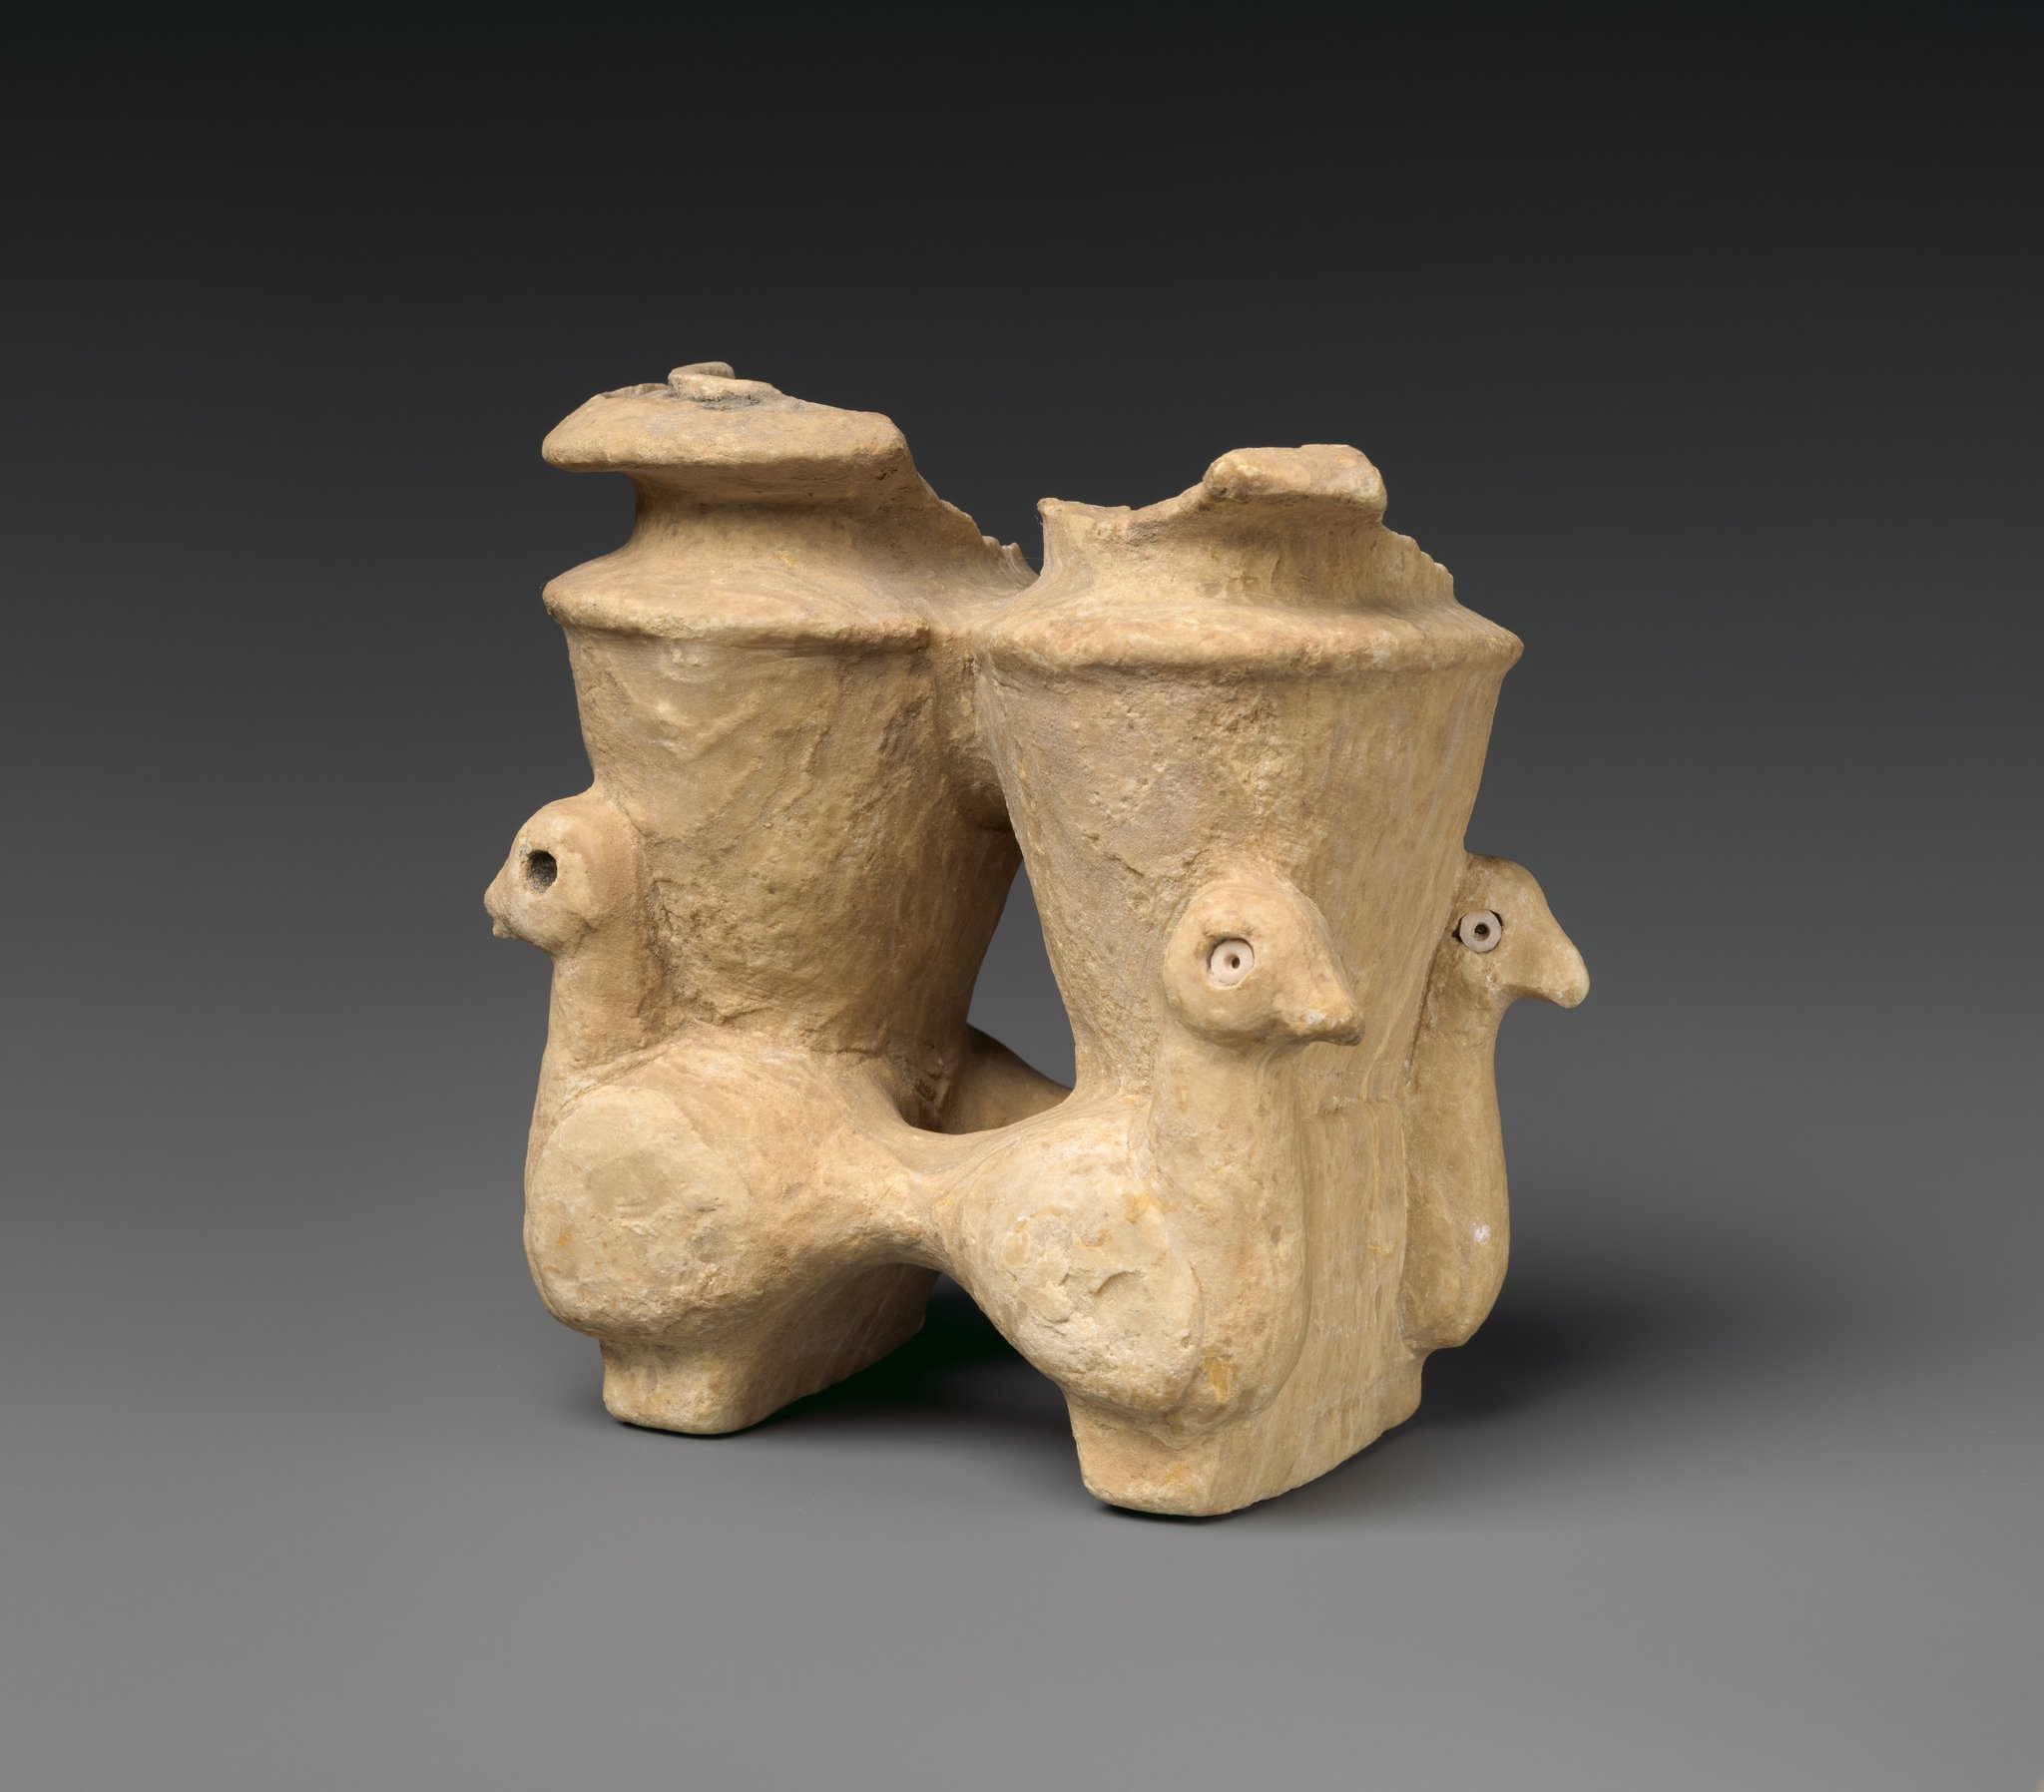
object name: vessel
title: Double vessel with duck-shaped supports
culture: sumerian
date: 2600-2500 BCE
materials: alabaster, gypsum, shell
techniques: inlay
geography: mesopotamia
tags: ducks